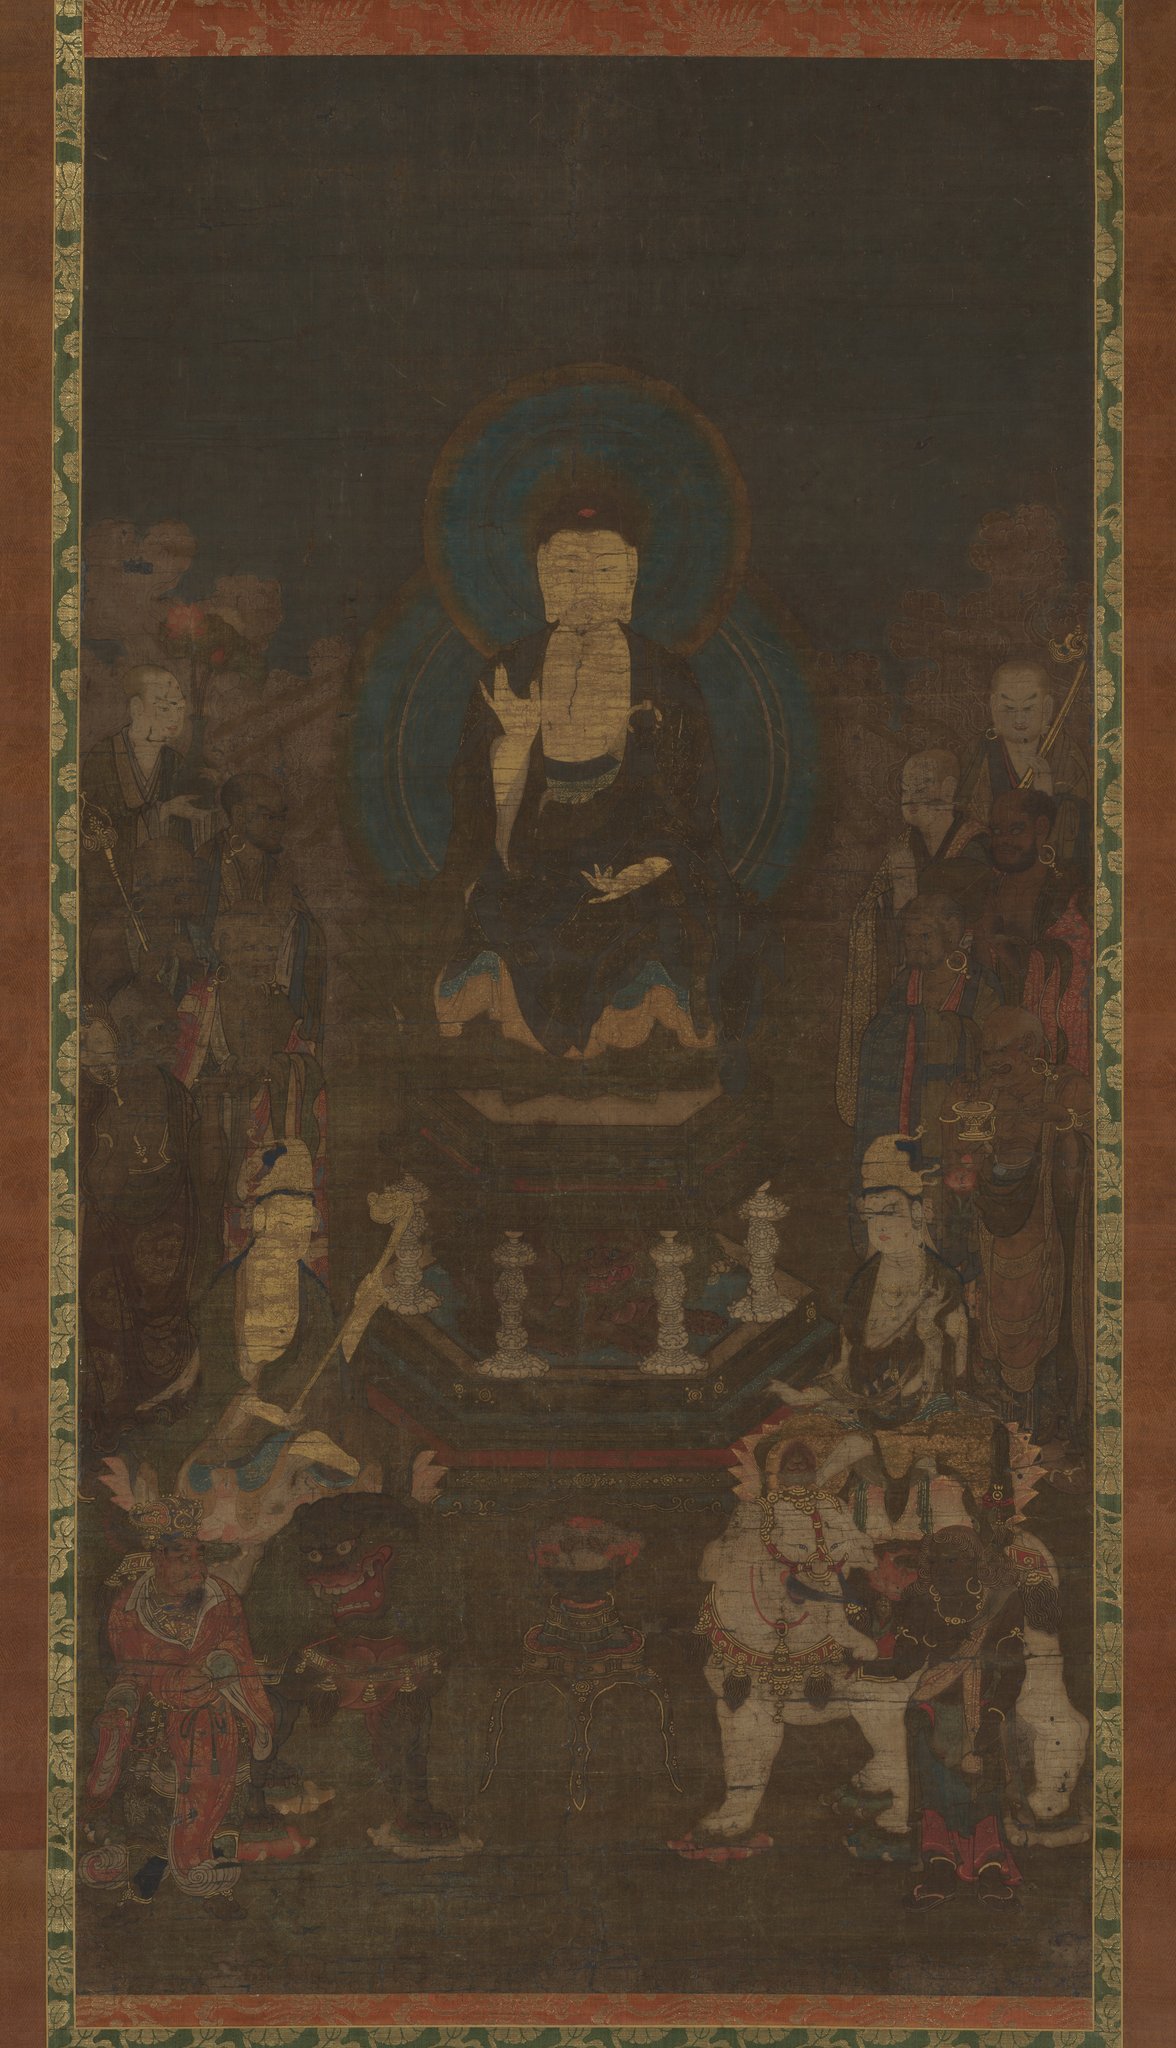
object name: hanging scroll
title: Shaka (Shakyamuni), the Historical Buddha, with Two Attendant Bodhisattvas and the Ten Great Disciples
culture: japanese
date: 1301-1333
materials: gold, ink, silk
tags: elephants,buddhism,bodhisattvas,buddha